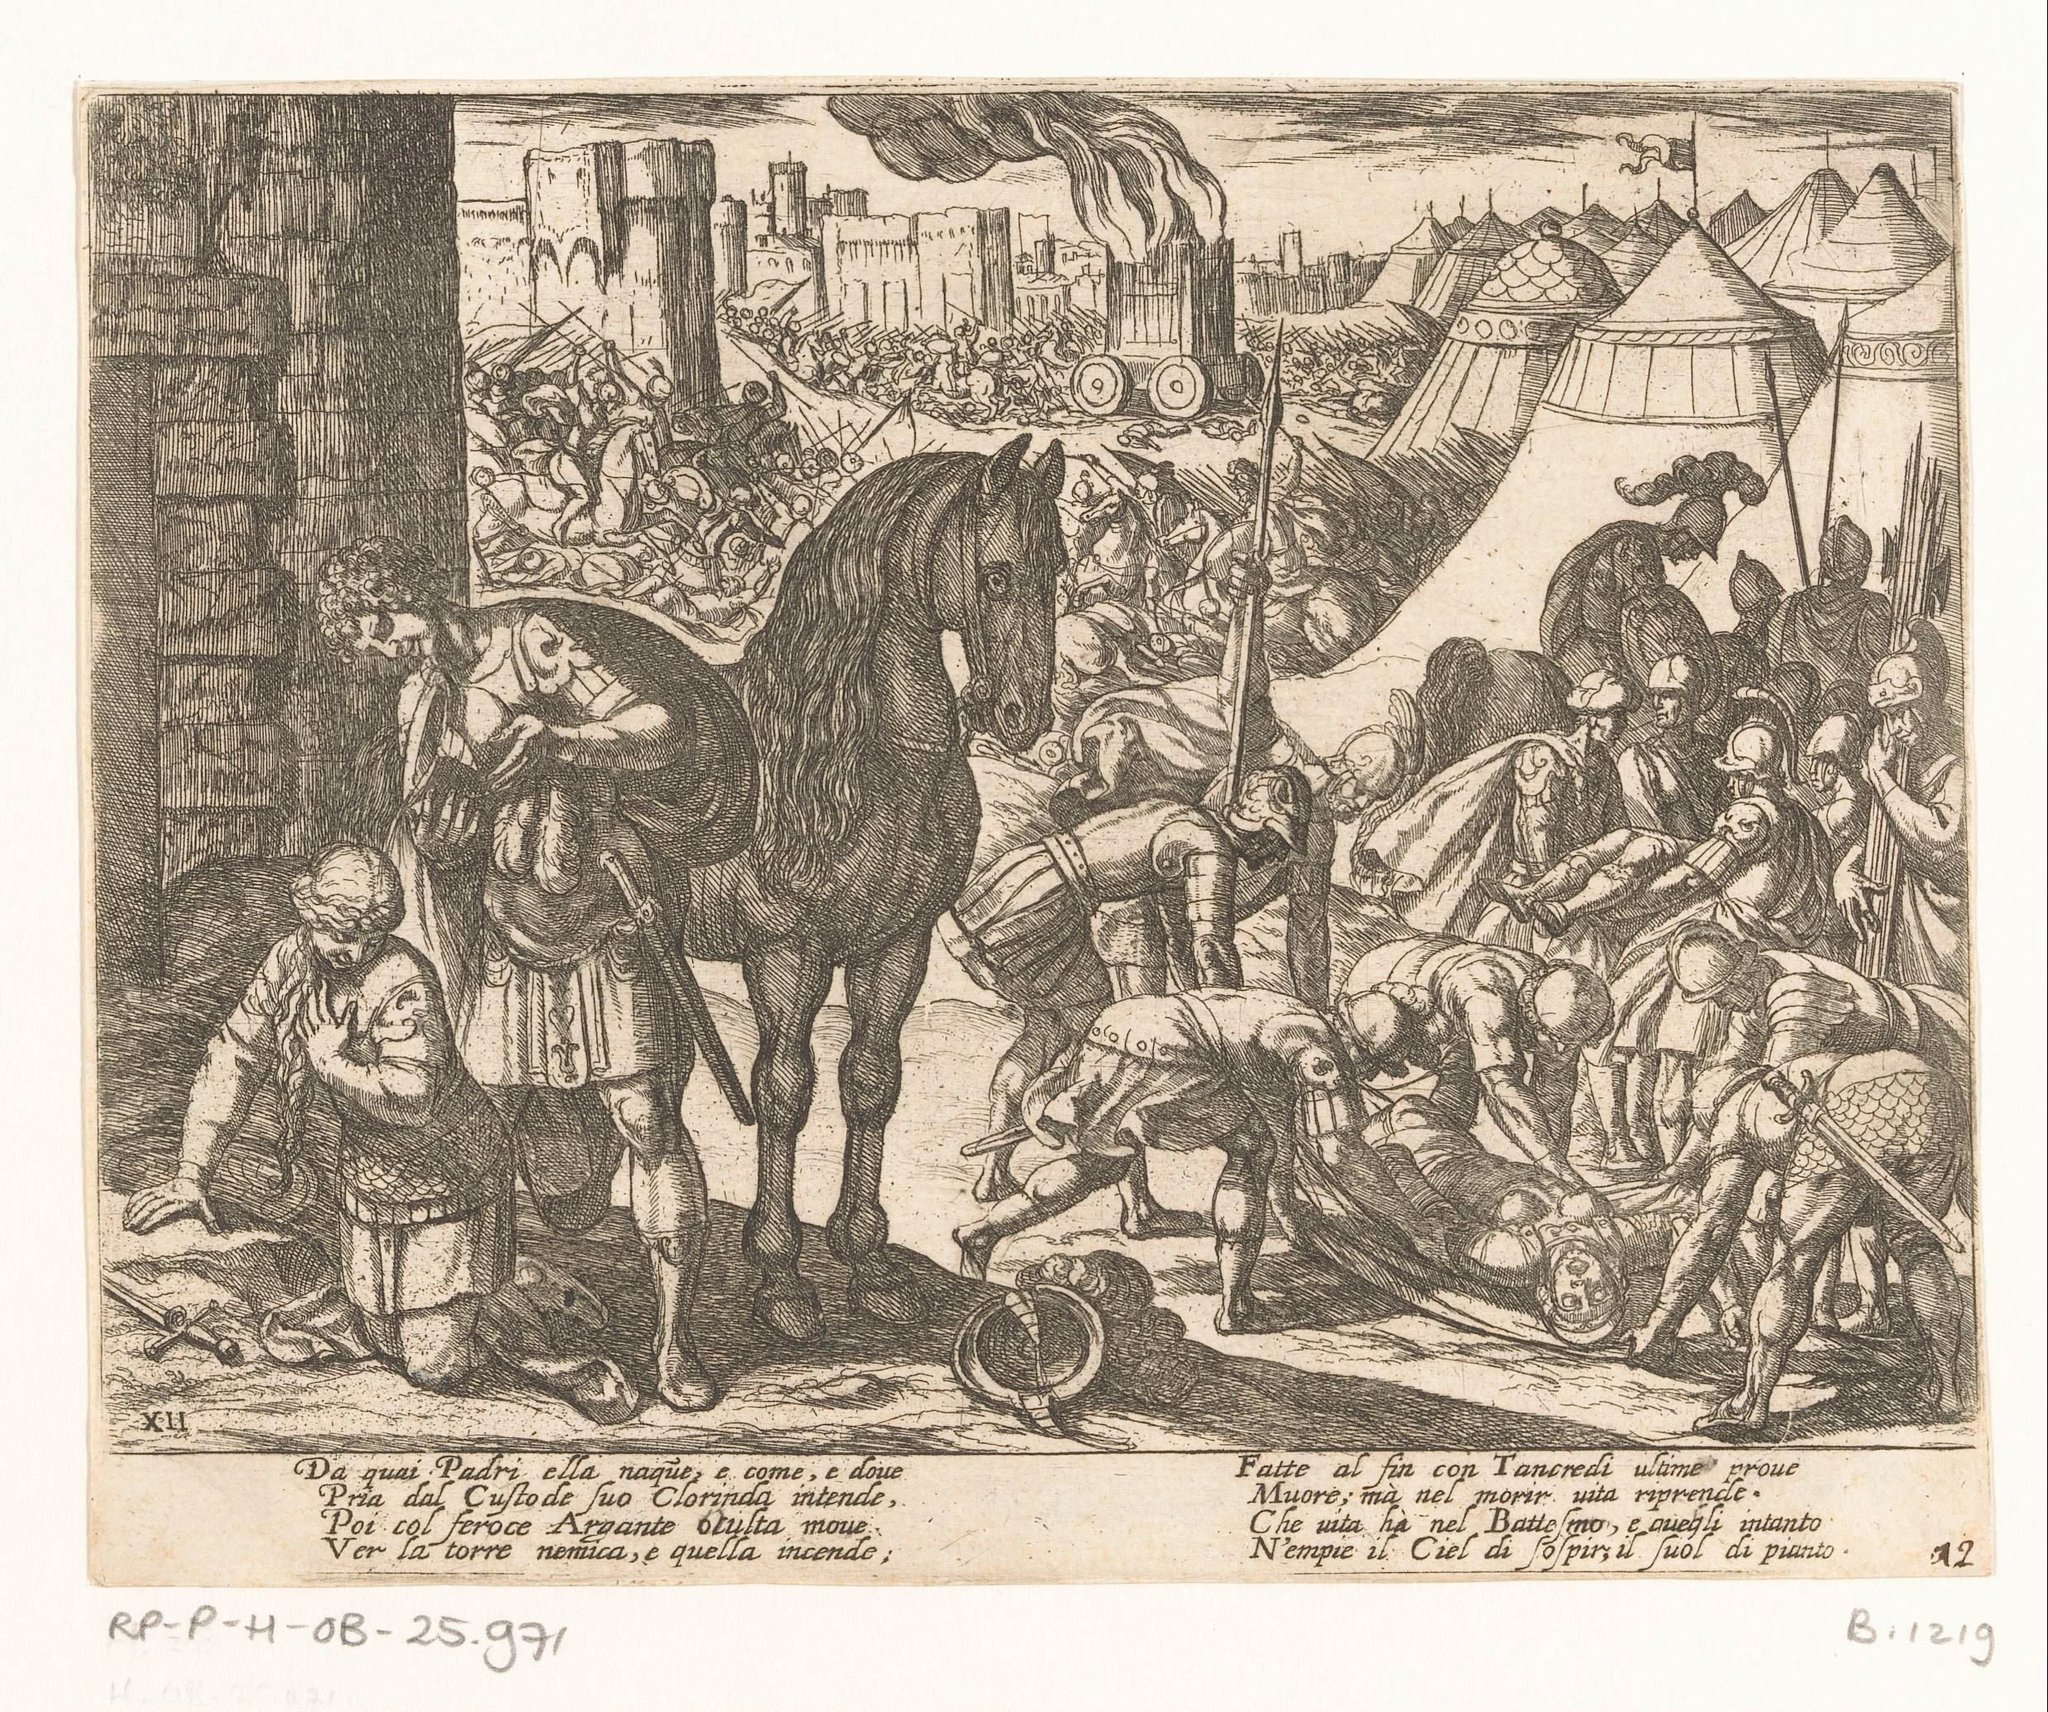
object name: print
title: Illustratie bij Canto II van Tasso's 'Gerusalemme Liberata'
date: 1565-1630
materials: paper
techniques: etching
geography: italy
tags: militant proselytizing: religious war, crusade, etc., (scenes from) specific works of literature: tasso, gerusalemme liberata, knight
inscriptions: collector's mark: Lugt 11, number: ‘12’, collector's mark: ‘Hinloopen’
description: Deze prent maakt deel uit van een reeks van twintig prenten (+ opdracht) met voorstellingen van scènes uit Tasso's 'Jeruzalem verlost', een episch gedicht geschreven door de Italiaanse dichter Torquato Tasso en voor het eerst gepubliceerd in 1581. Het verhaal vertelt grotendeels in fictie over de Eerste Kruistocht waarin de christenen, geleid door Godfried van Bouillon, de strijd aangaan met de moslims om het Beleg van Jeruzalem.